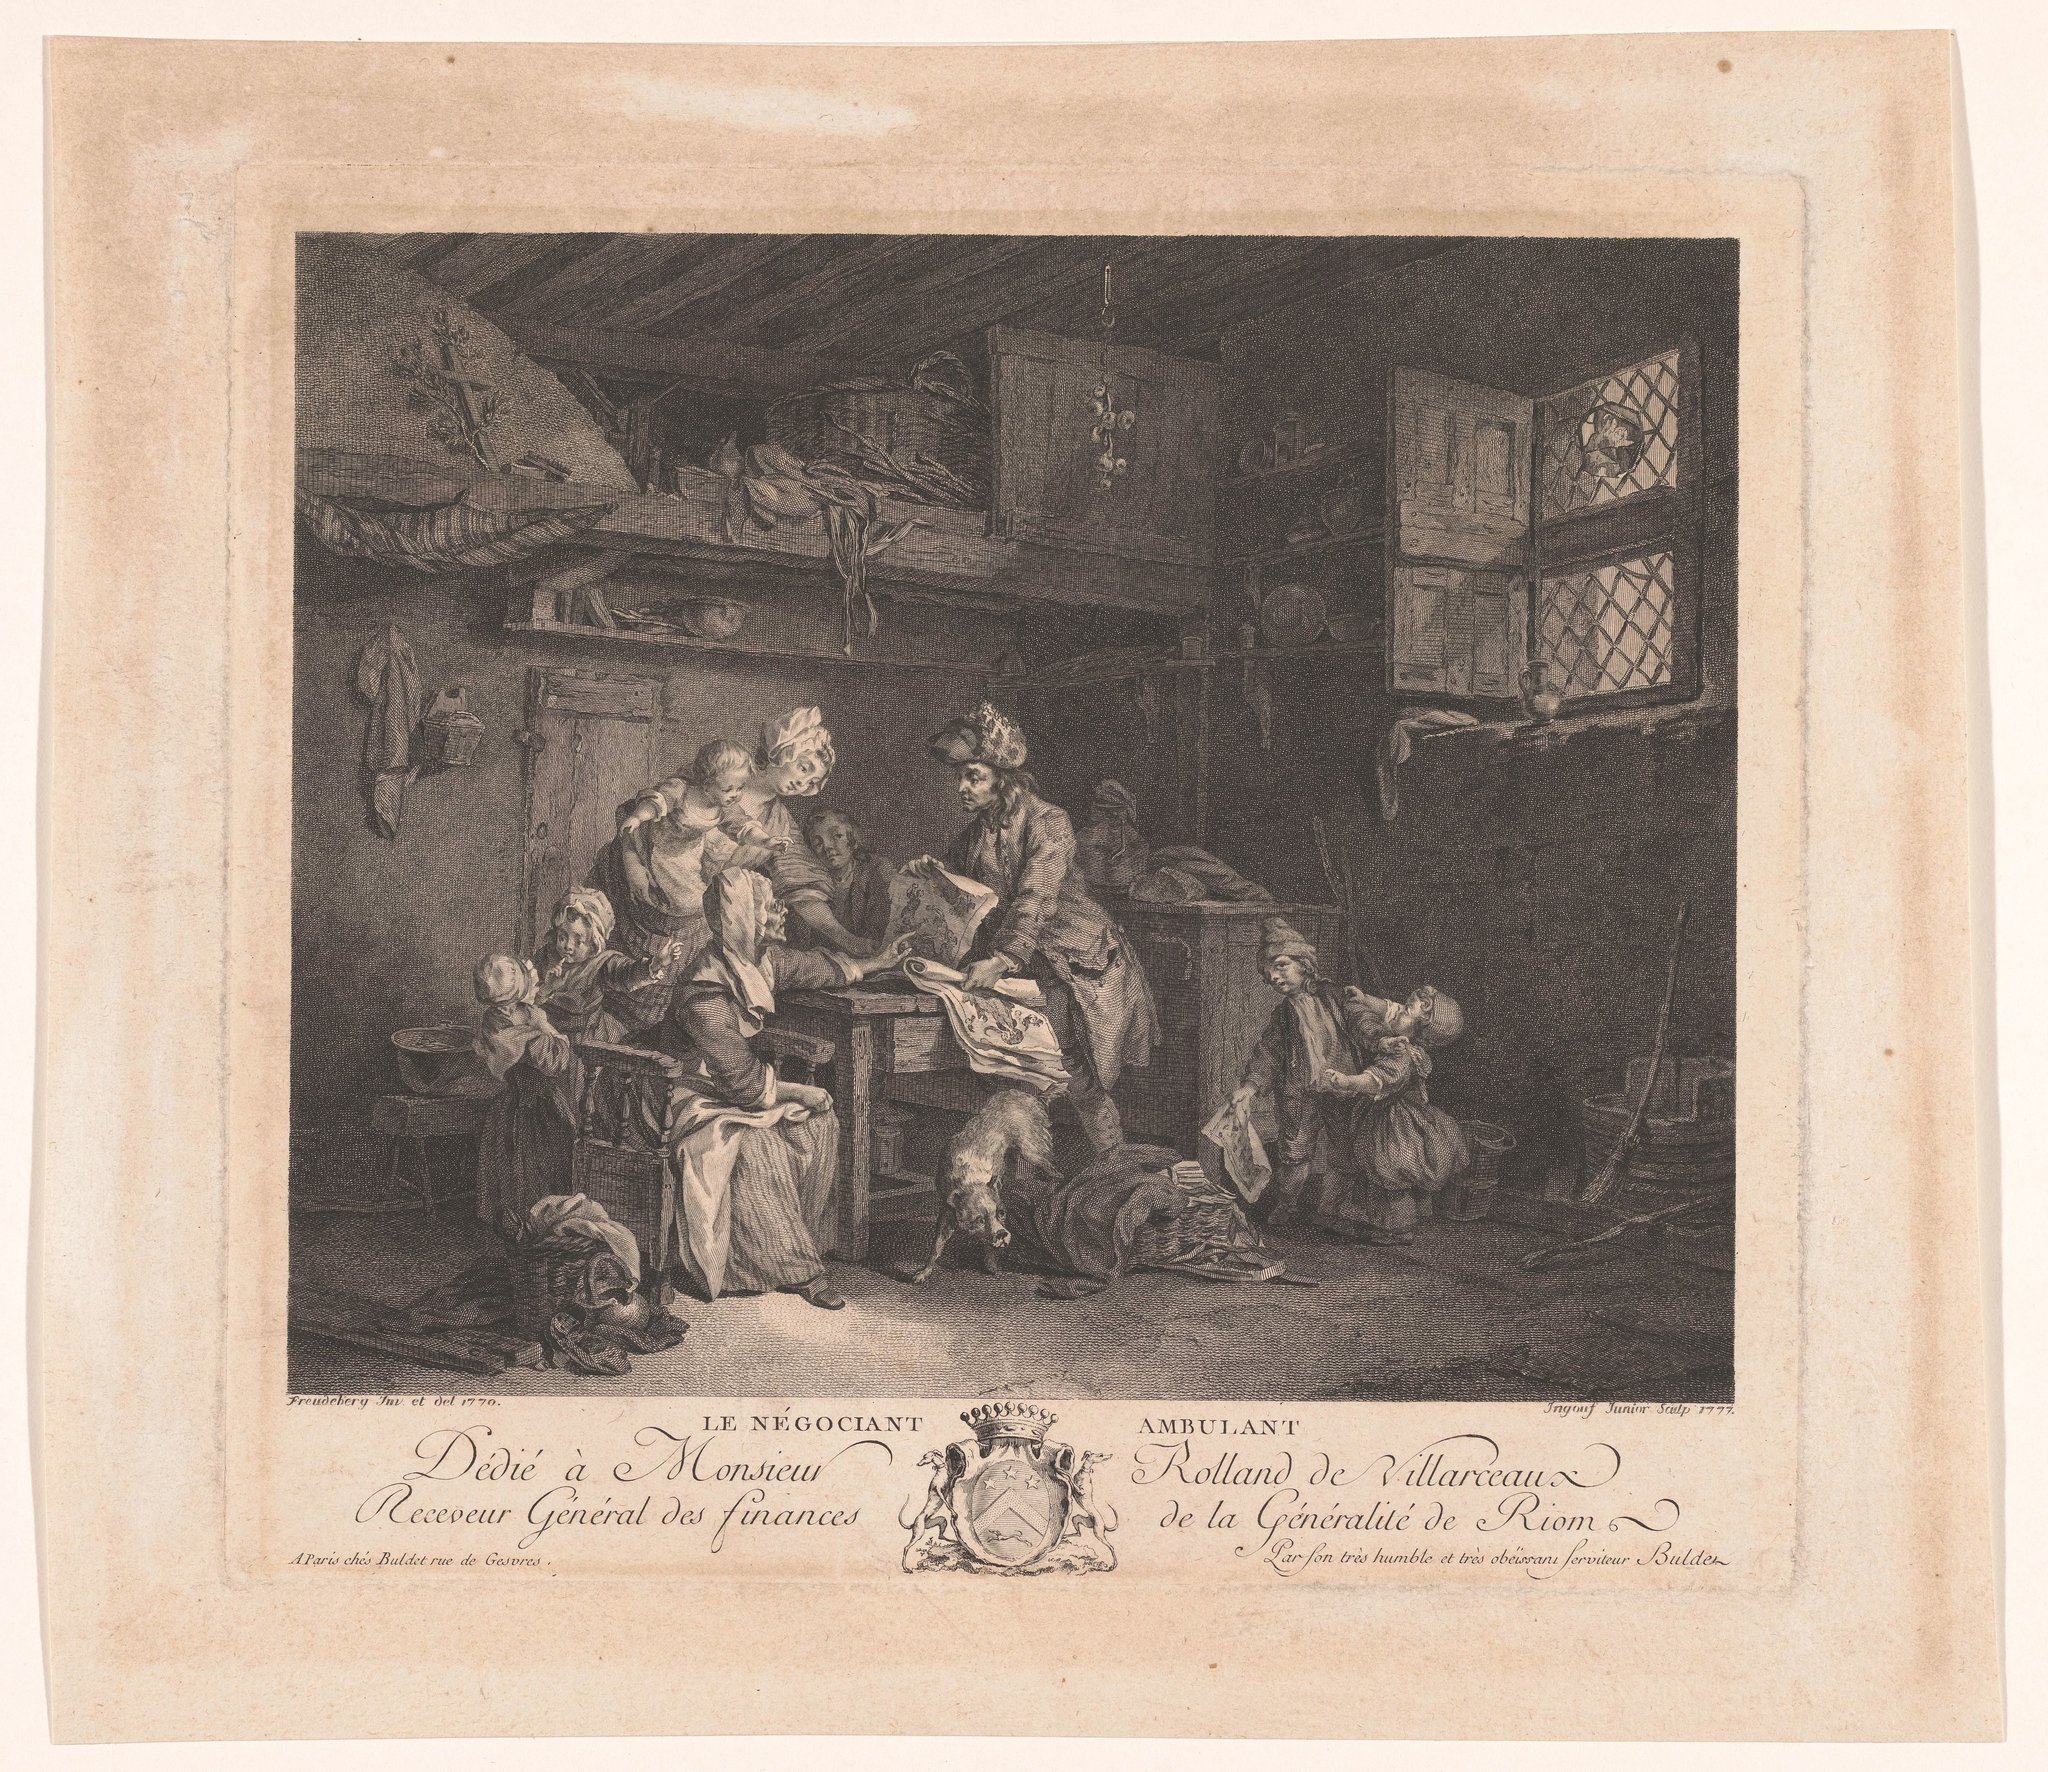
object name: print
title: Le négociant ambulant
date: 1777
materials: paper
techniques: engraving, etching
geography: paris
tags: print, e.g.: engraving, etching, lithograph, art dealer (+ graphic arts), book, farm (building) - aa - civic architecture: inside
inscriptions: collector's mark: Lugt 4780, collector's mark: Lugt 2228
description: Achter de tafel van een boerenwoning staat een rondreizende prenthandelaar. Hij toont zijn koopwaar aan een vrouw met een kind op haar arm en een zittende oude vrouw. Rechts vechten twee kinderen om een prent. Onder de afbeelding het wapen van Louis Rolland de Trémeville, heer van Villarceaux.